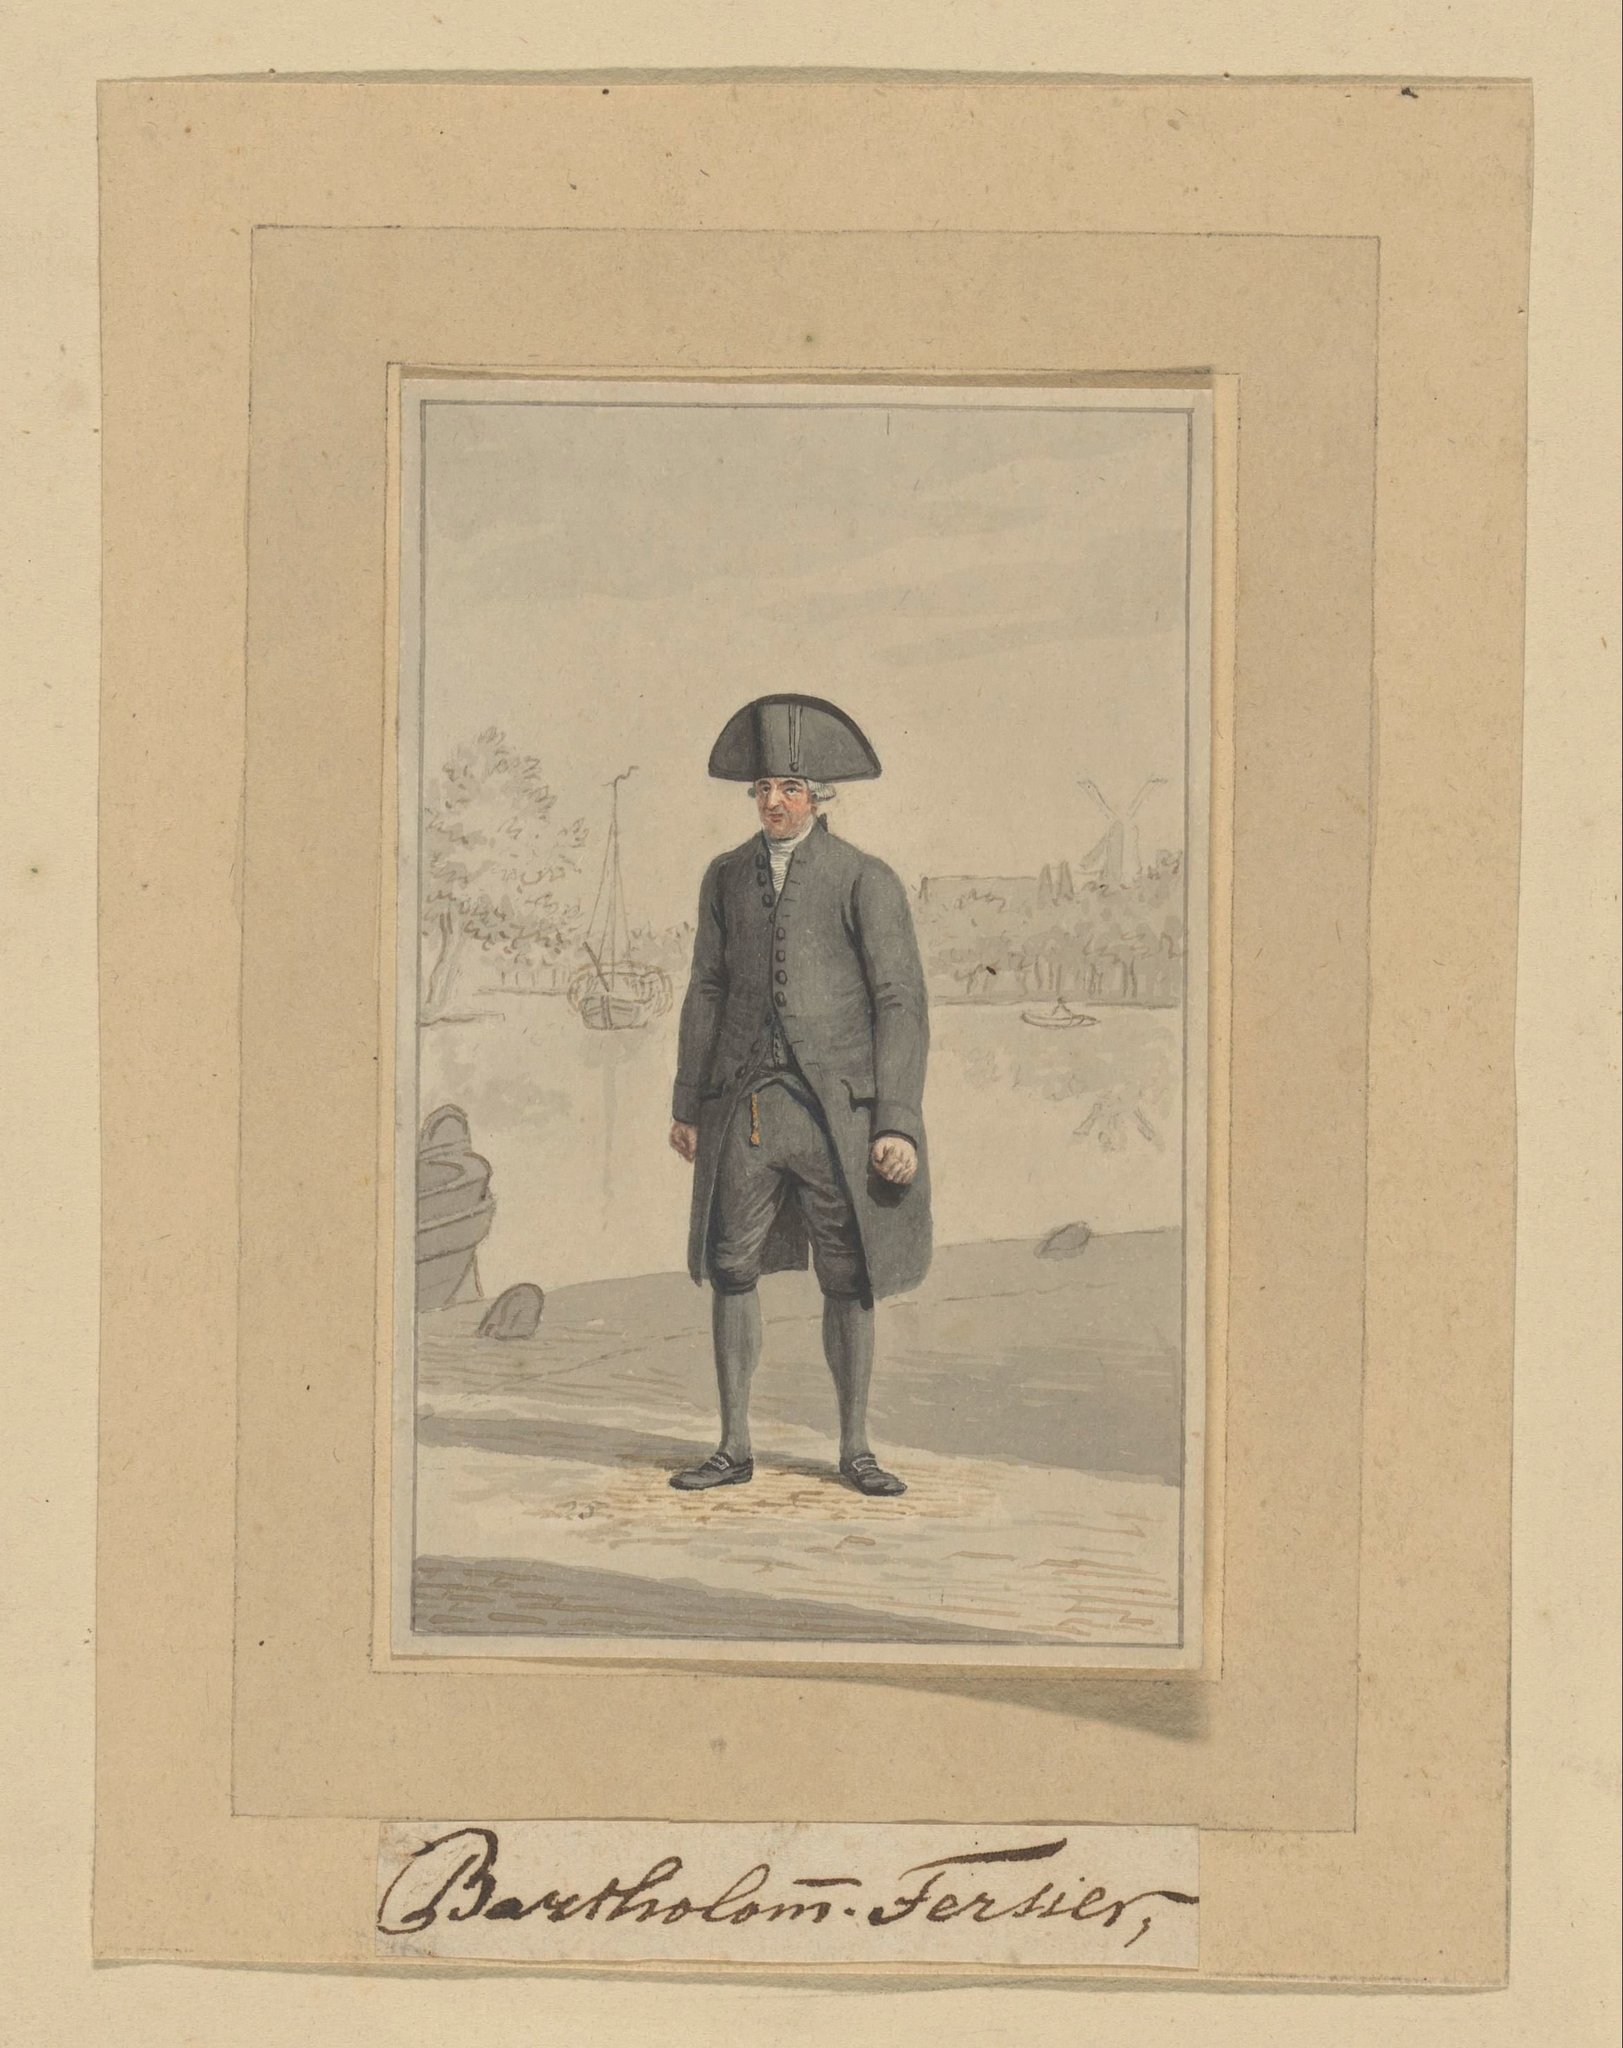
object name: drawing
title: Bartholomeus Fersier, wandelend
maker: joannes pieter visser bender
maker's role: draughtsman, print maker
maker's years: 1785-1813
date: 1795-1813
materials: paper, watercolor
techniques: brush, pen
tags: historical persons, haarlem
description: Bartholomeus Fersier, medicus te Haarlem, op zijn wandeling aan het Spaarne.